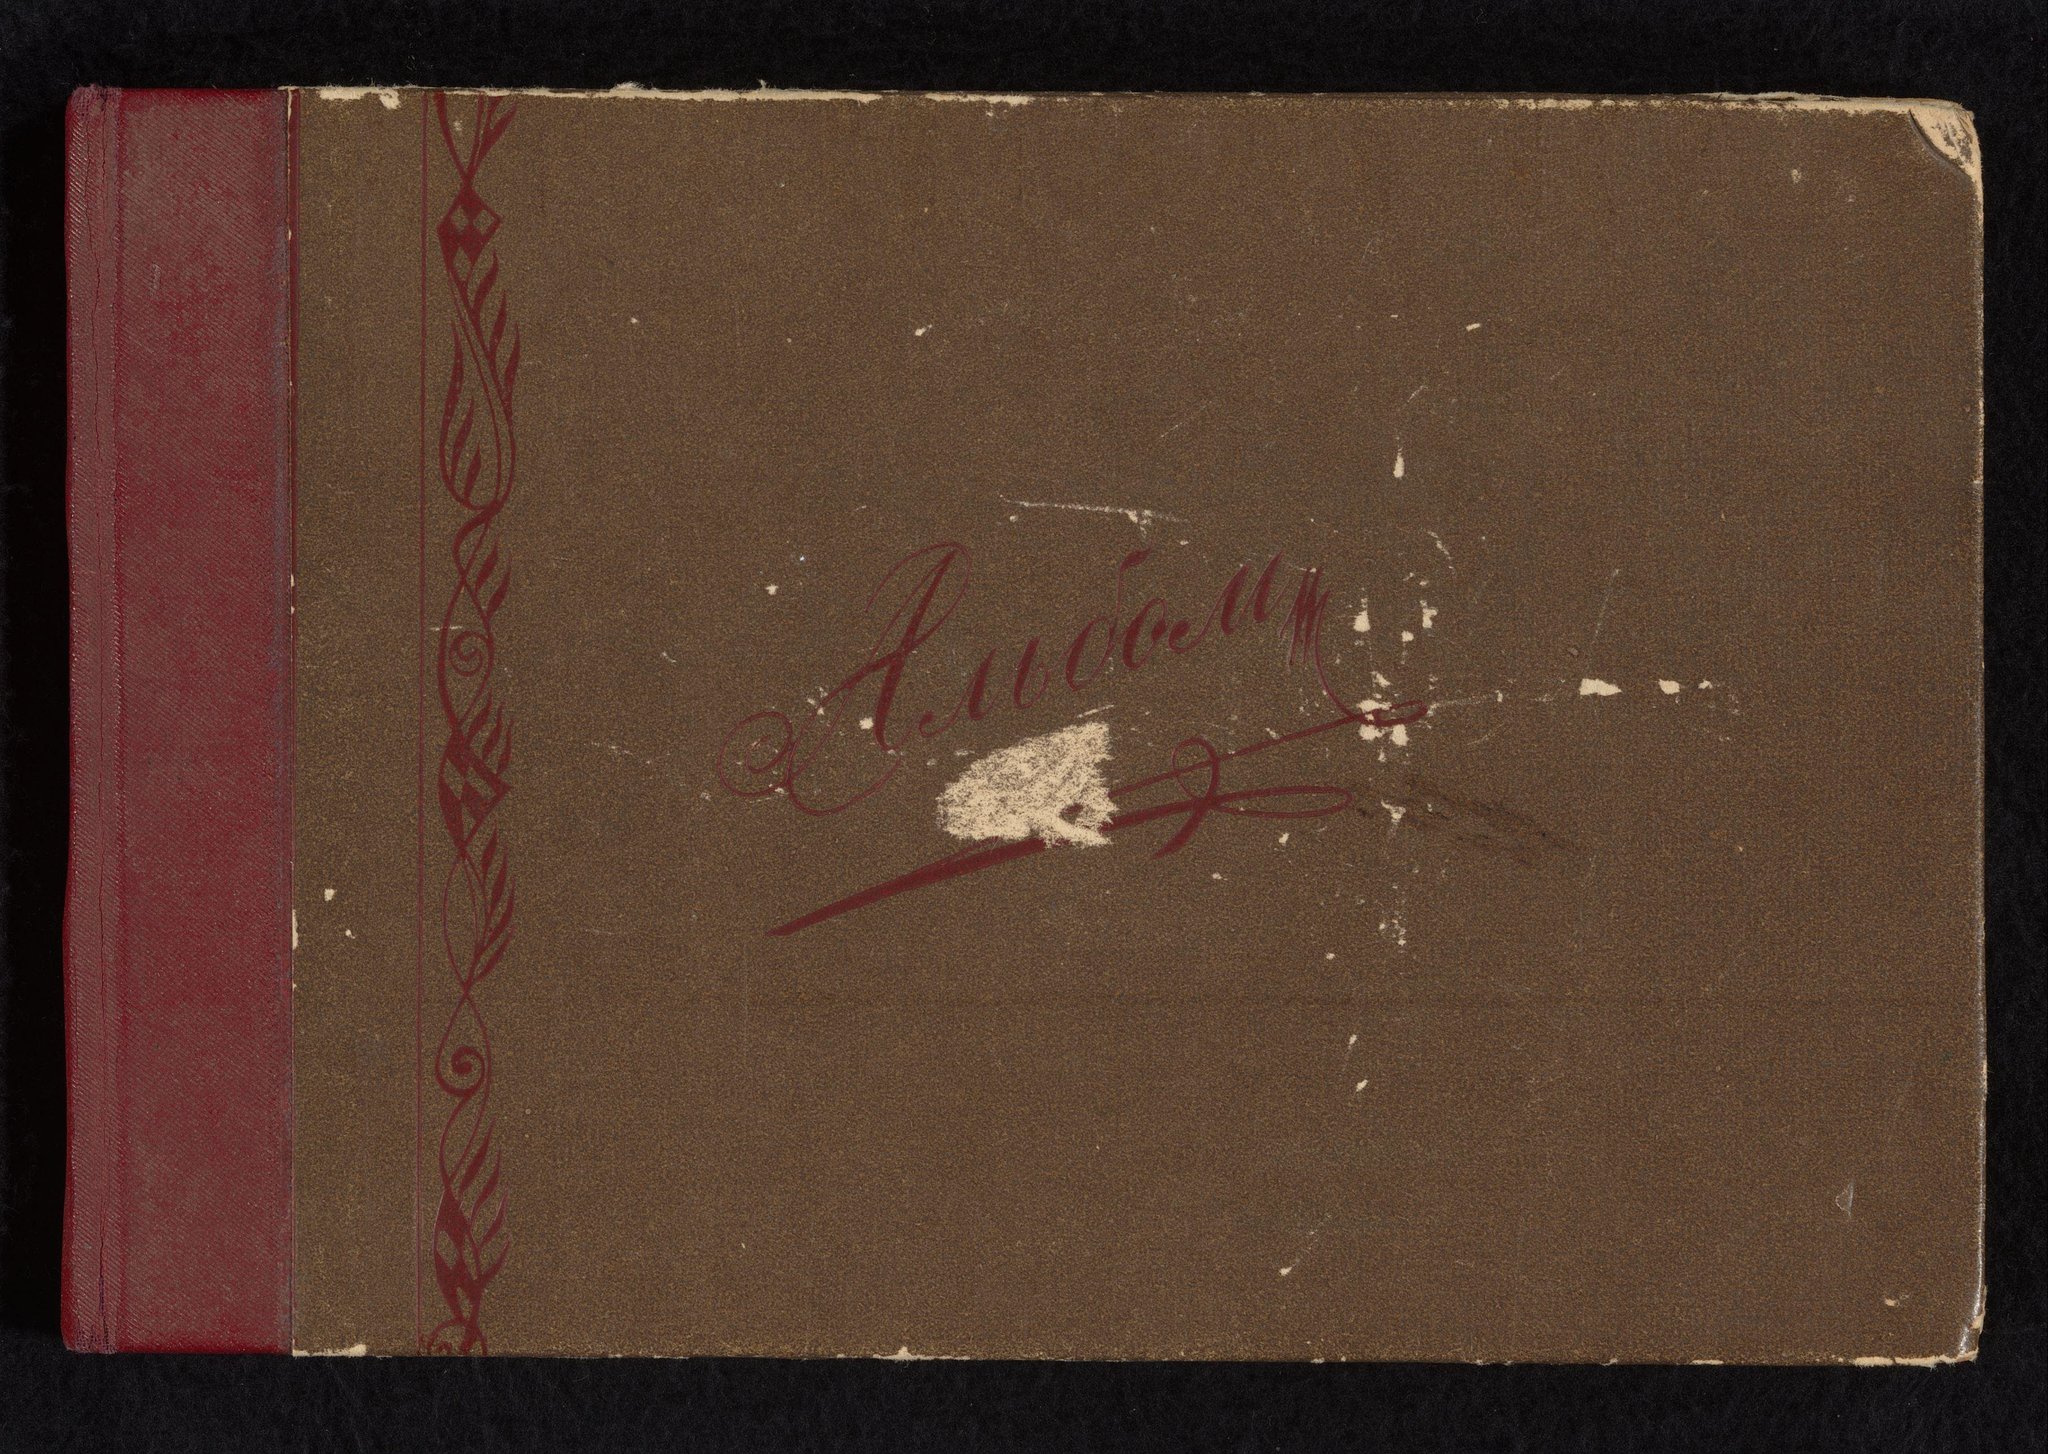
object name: photograph album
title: Duits militair album Tweede wereldoorlog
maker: Anonymous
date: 1940-1975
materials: paper, photographic support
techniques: gelatin silver print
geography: germany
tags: netherlands, germany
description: Duits militair fotoalbum met een bruin papieren omslag met rode rug en opschrift in het Russisch "Album". Hierin 50 grijze binnenbladen in omslag gebonden. Het binnenwerk is voorzien van 61 zwart-wit foto's. 31 bladen blanco. Het album heeft waarschijnlijk toebehoord aan Dieter Glitsch uit Hardegsen. Hij behoorde tot een Luftwaffe Einheit. Vermoedelijk heeft hij na 1945 3 jaar in Russische gevangenschap doorgebracht. De foto's tonen het soldatenleven, eerst waarschijnlijk voor de oorlog in Duitsland en een klein deel in Nederland. De laatste bladzijden gaan over een Volkswagen fabriek. Bij het album behoort nog een groep van 39 losse foto's. Hierbij ook los een knipsel over de herdenking van het einde van WO II met de Russische president Poetin uit de Heute van 9 mei 2001.